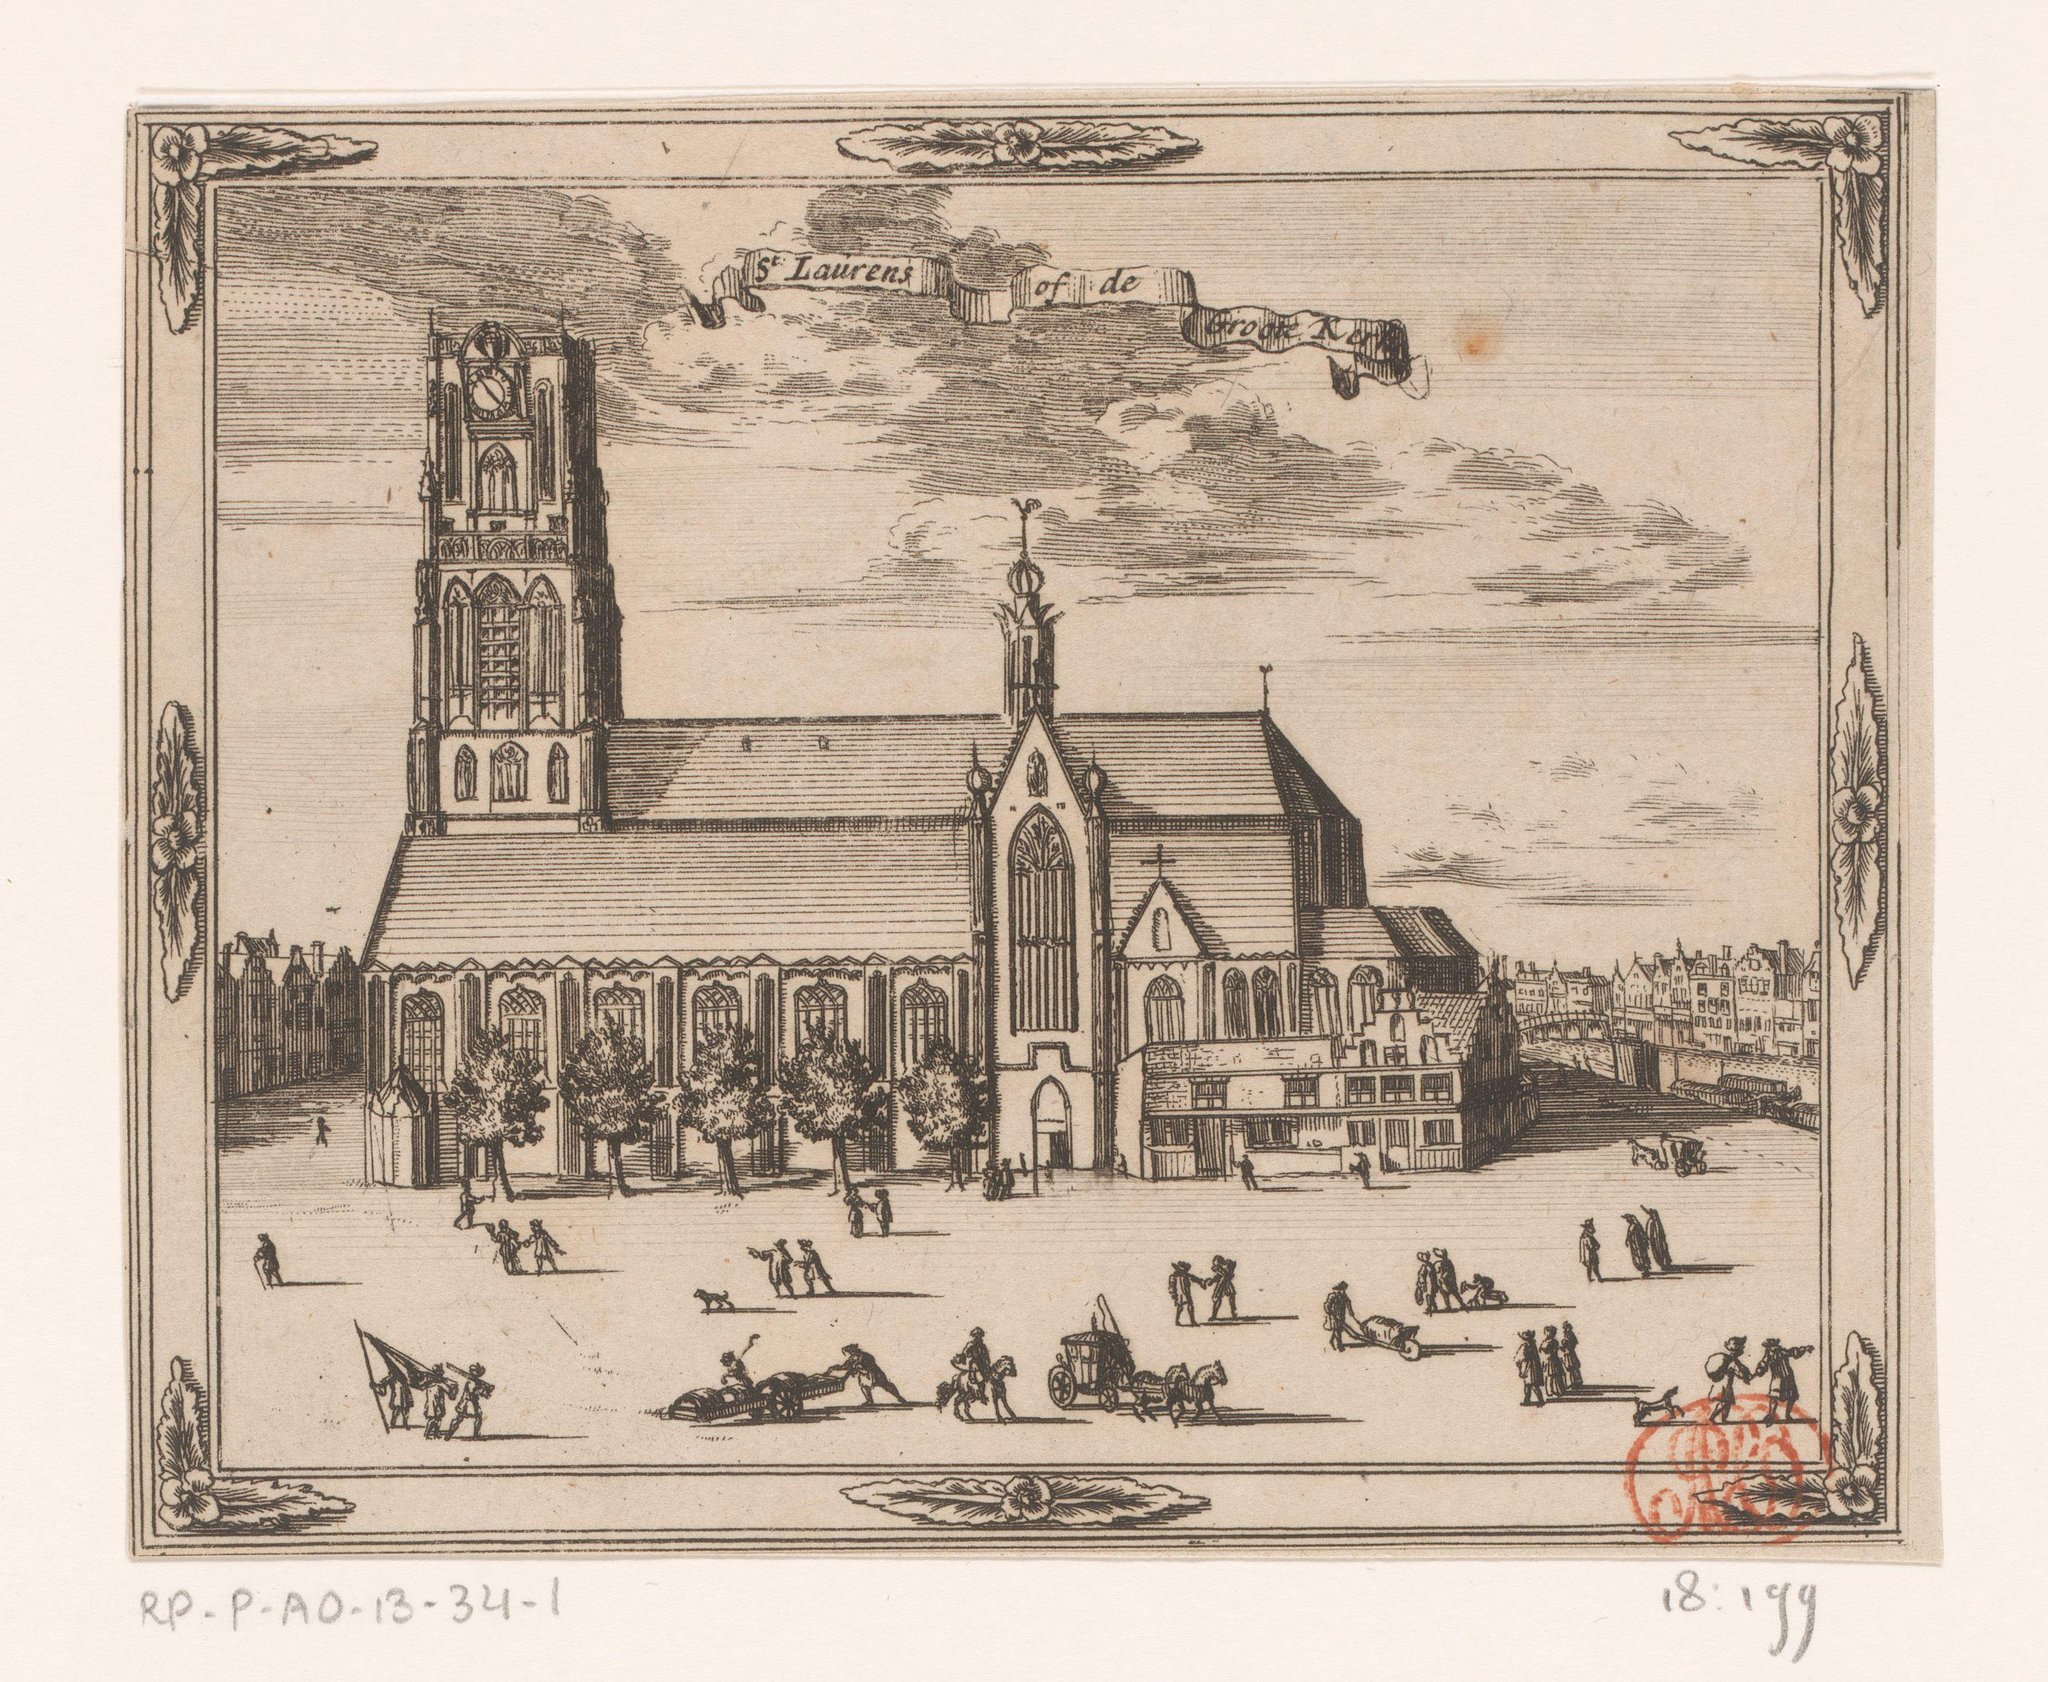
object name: print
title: Gezicht op de Grote of Sint-Laurenskerk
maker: jacobus harrewijn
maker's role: print maker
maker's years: 1660-1740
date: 1715-1730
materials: paper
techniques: etching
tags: church (exterior), square, place, circus, etc. (+ city(-scape) with figures, staffage)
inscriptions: collector's mark: Lugt 195, collector's mark: Lugt 2228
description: Prent vermoedelijk eerst met dertien andere stadsgezichten uitgegeven als onderdeel van de sierrand van – in ieder geval de derde staat en mogelijk ook de tweede van – de plattegrond 'Tabula Roterodami Novissima' (zie RP-P-AO-13-11). Later nog een keer als onderdeel van een prentserie uitgegeven: Les principaux edifices et vues de la ville de Rotterdam. Le tout fidèlement dessiné sur les lieux. Leiden: Pieter van der Aa, s.a. [adres 'dans l'Academie', dus 1715-1730]. De platen zijn voor zover na te gaan ongewijzigd gebleven.